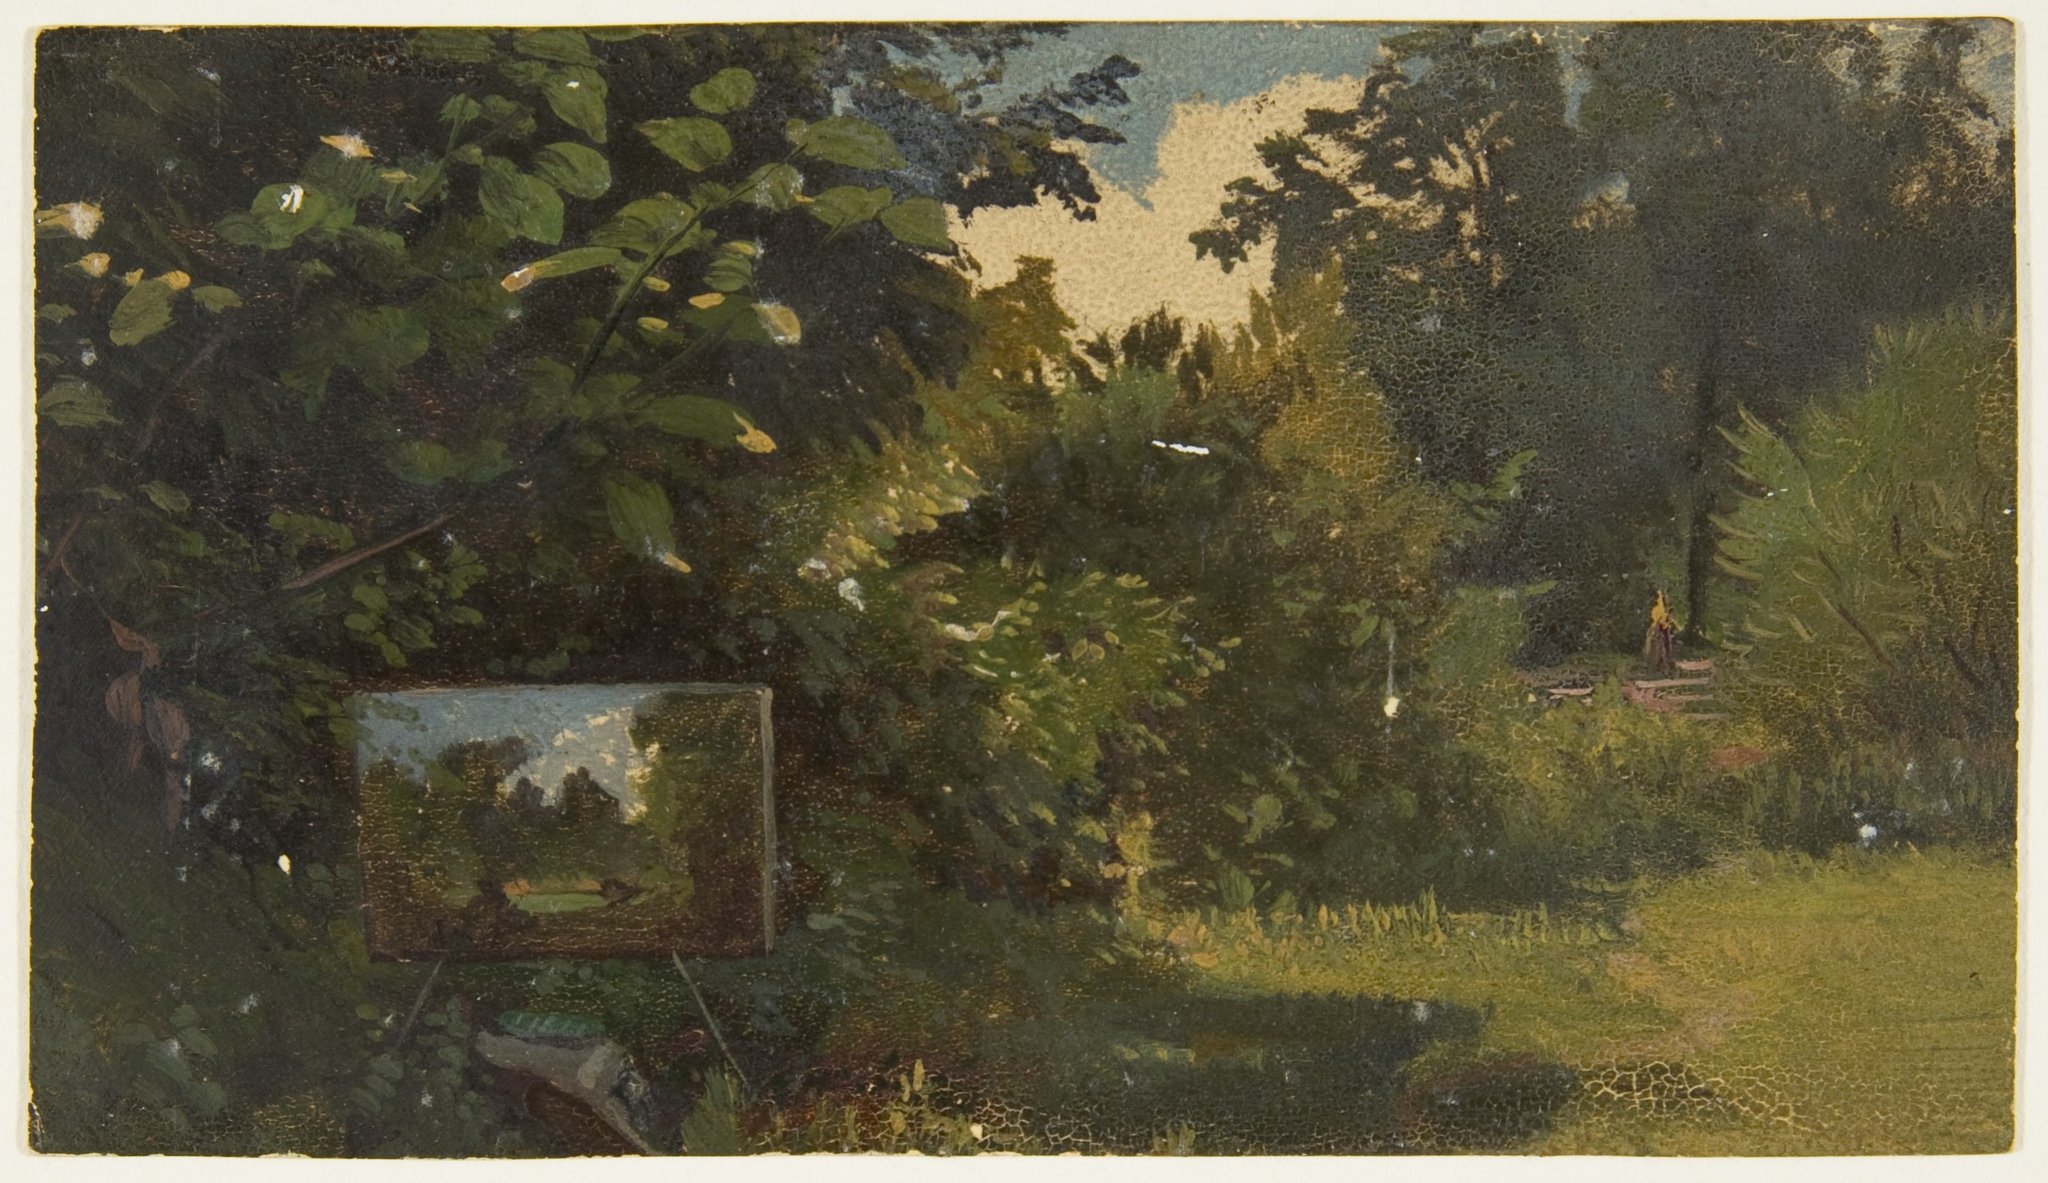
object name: drawing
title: Landscape with an Easel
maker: anonymous, french, 19th century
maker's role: artist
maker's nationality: french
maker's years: 1800-1900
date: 1801-1900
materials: oil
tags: landscapes,trees